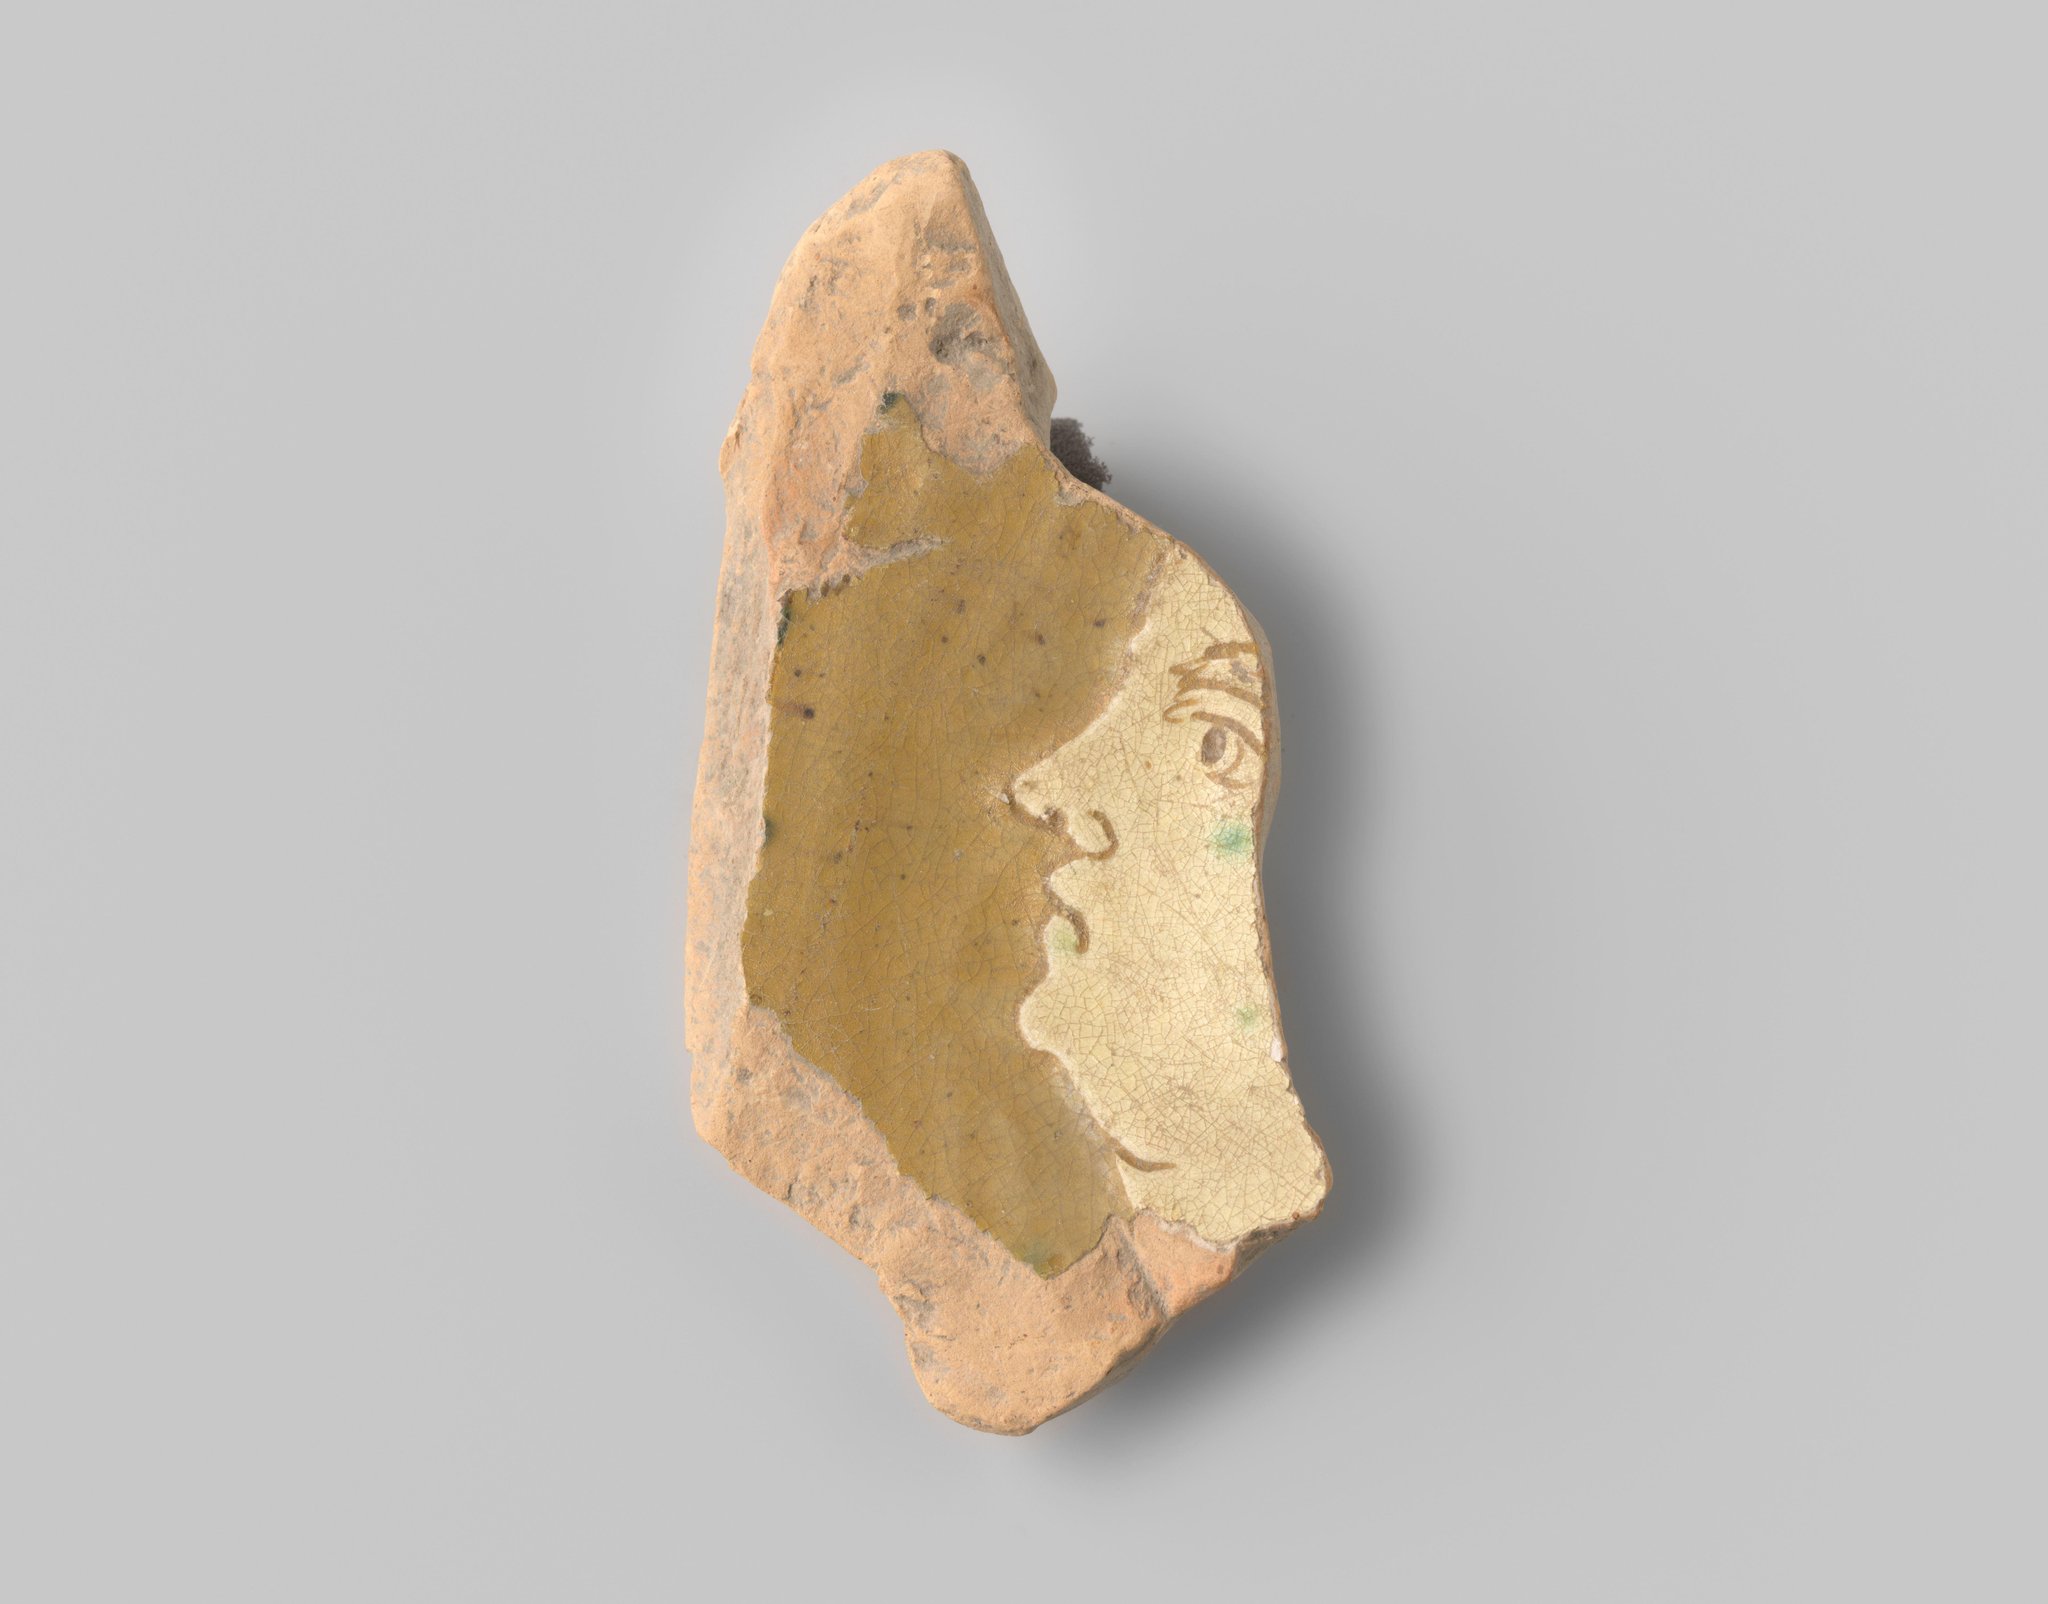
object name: sherd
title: Fragment (voet) met rossige scherf, in sgraffito-techniek een wit vrouwenhoofd op beige grond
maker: Anonymous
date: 1200-1899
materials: earthenware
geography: italy